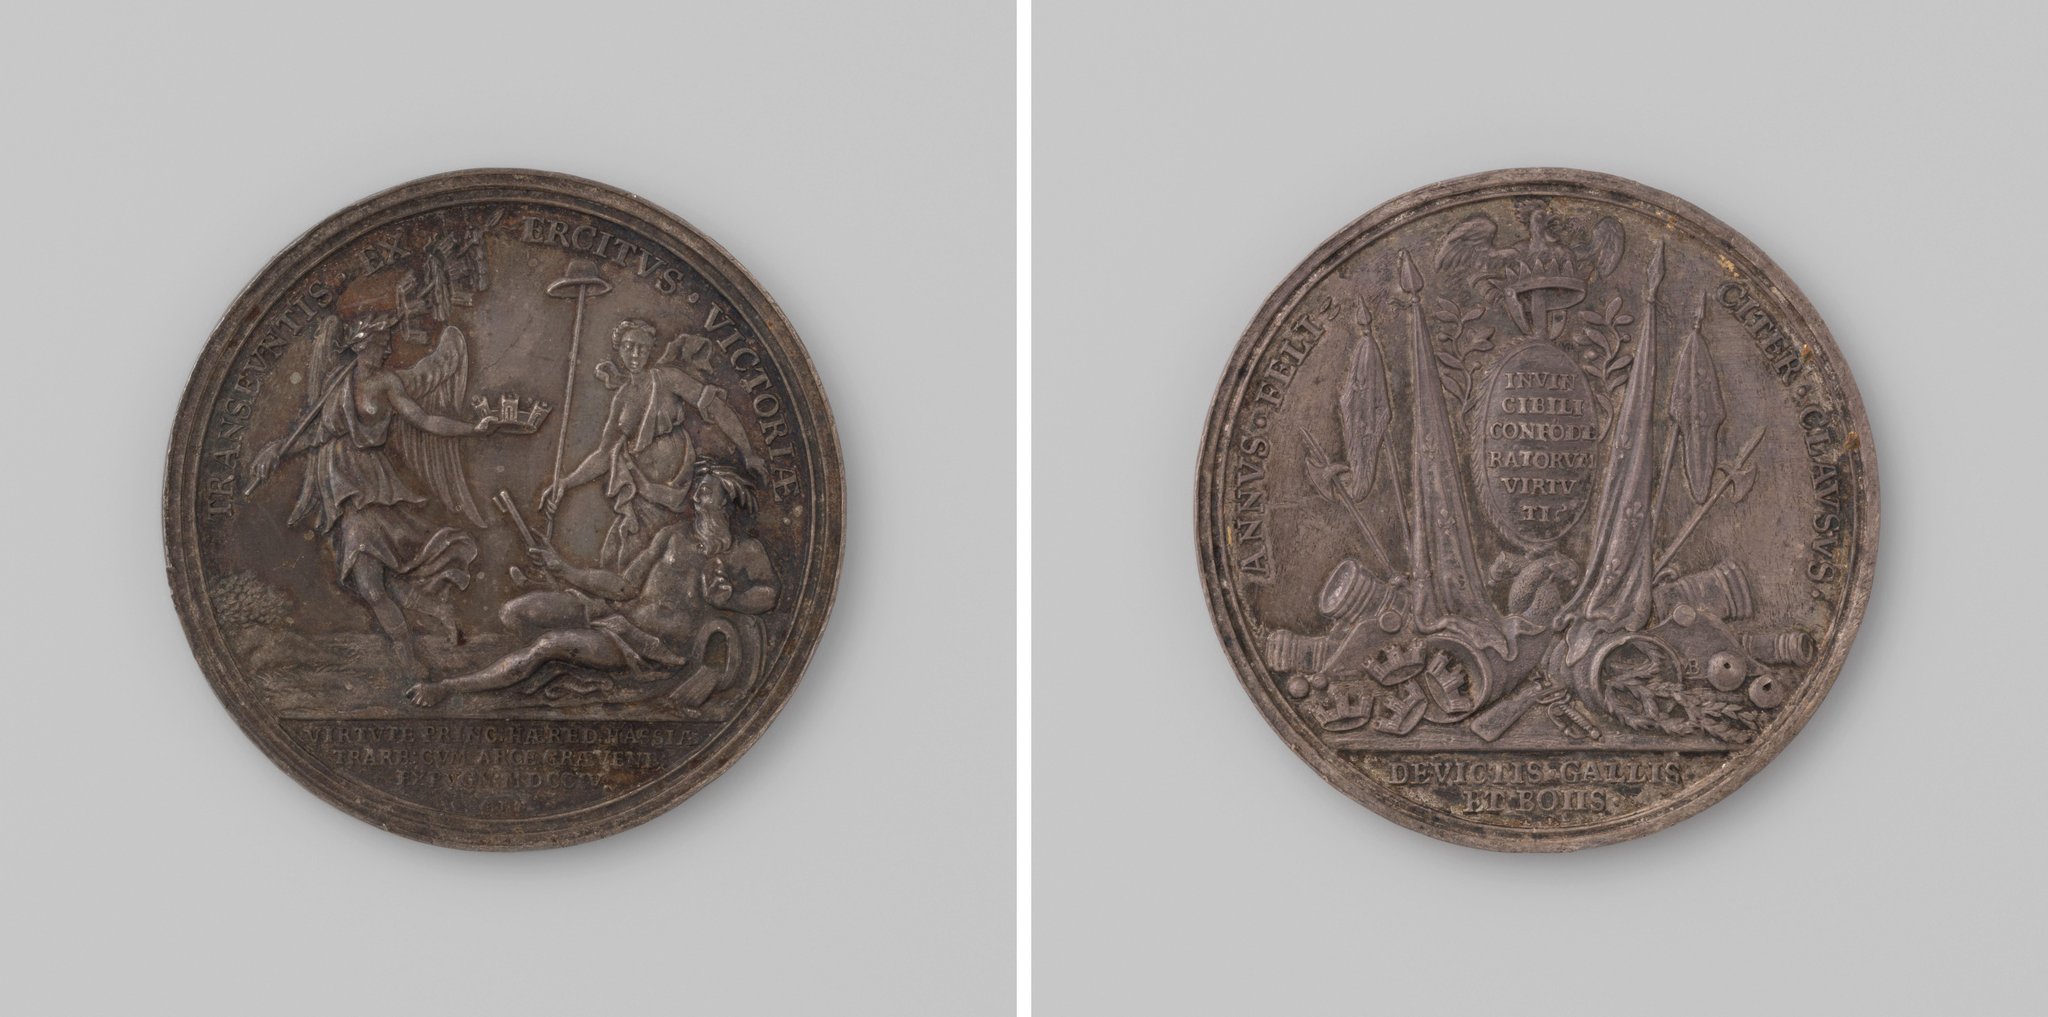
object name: history medal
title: Verovering van Grevenburg door Frederik, erfprins van Hessen-Kassel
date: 1704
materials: silver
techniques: striking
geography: nuremberg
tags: frederik i (koning van zweden)